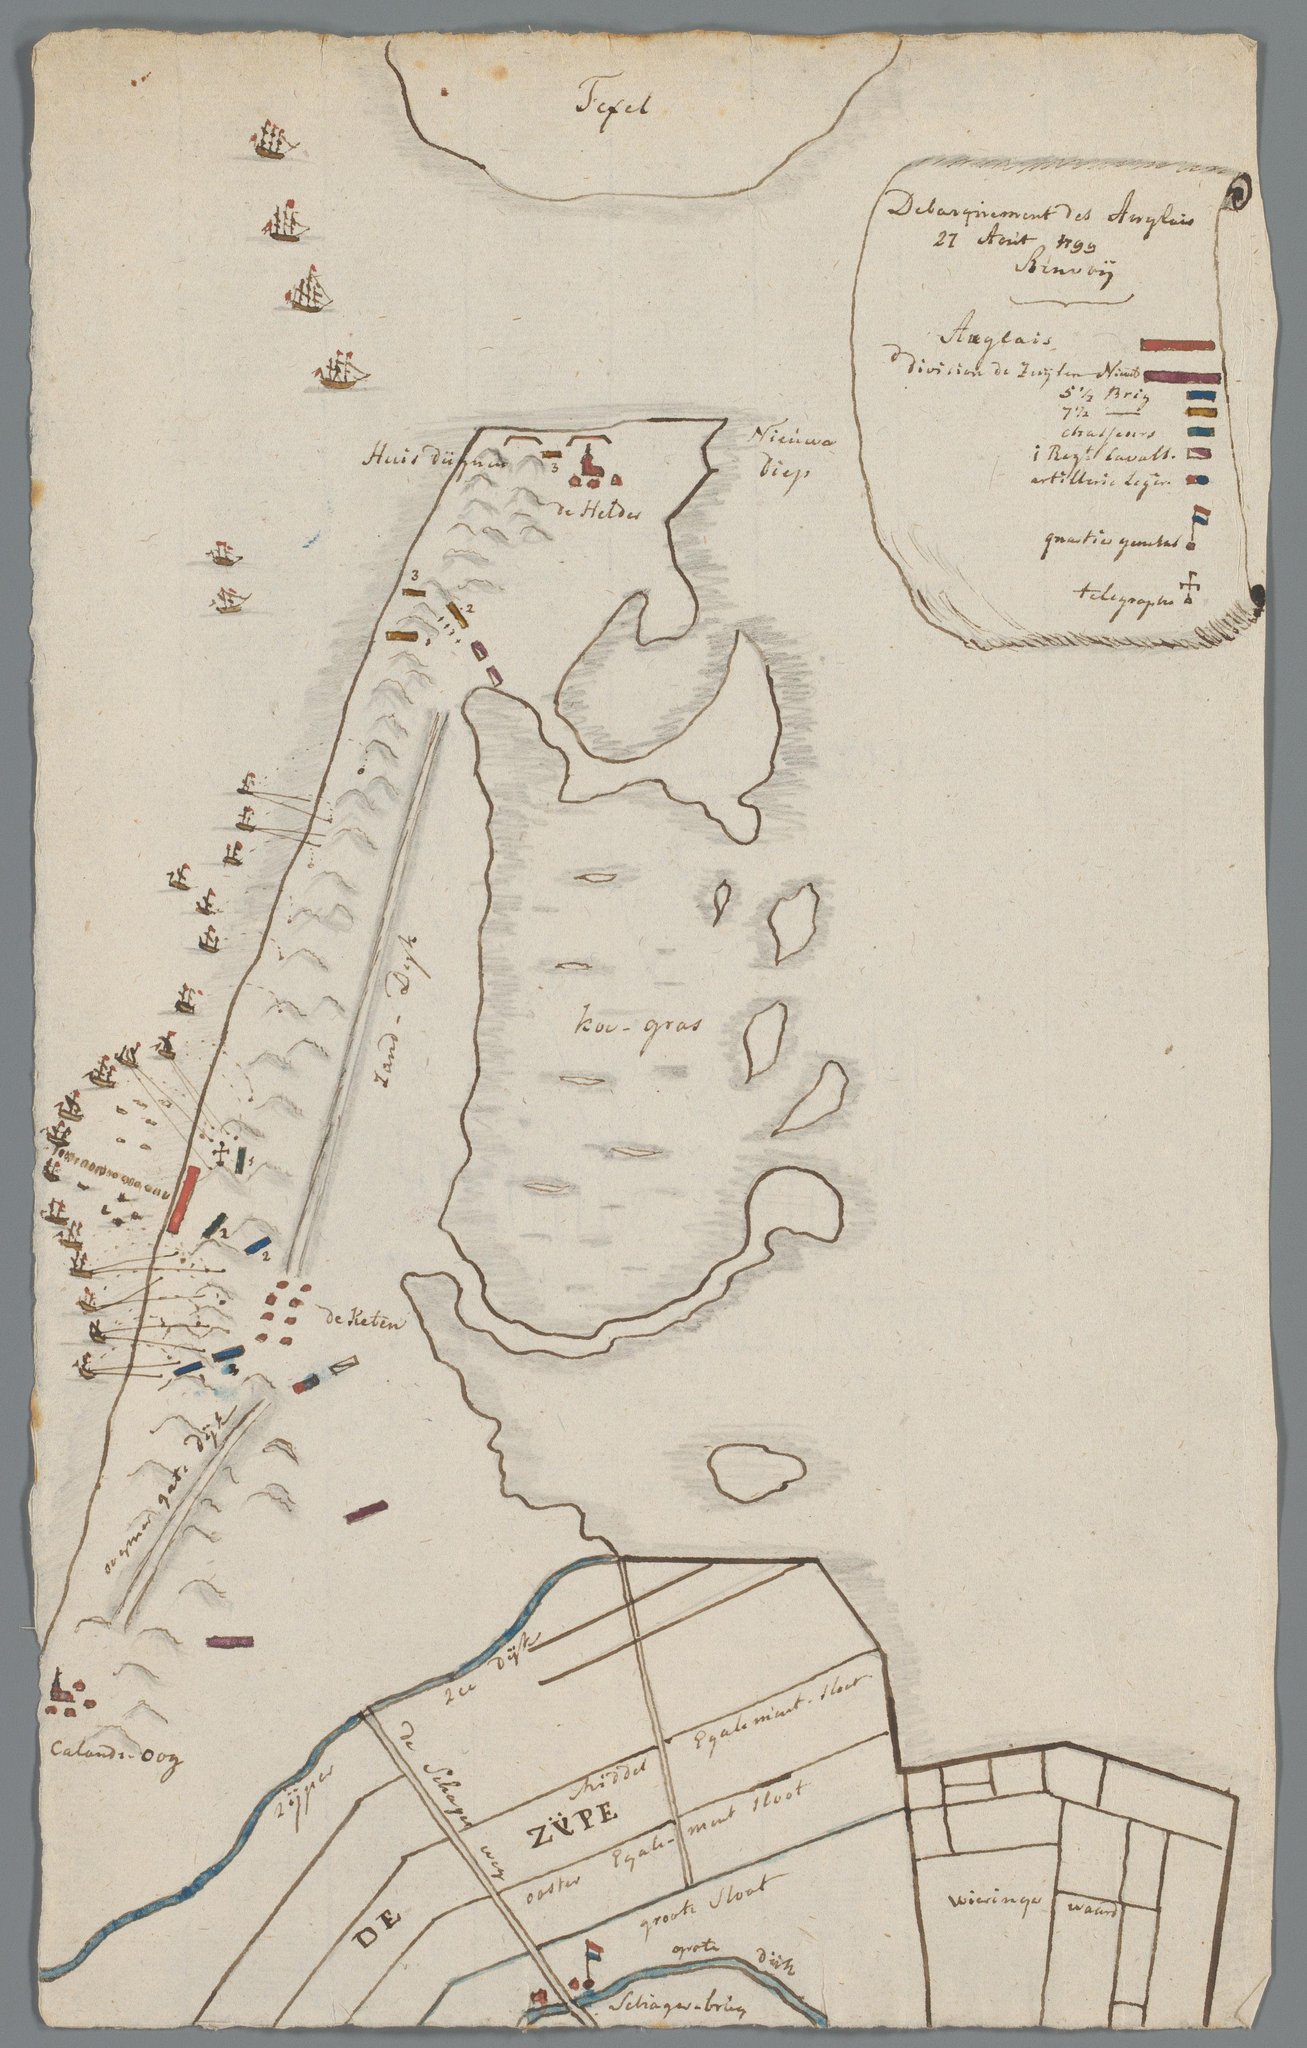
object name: drawing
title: Debarquement des Anglais 27 Aout 1799 Renvoij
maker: hendrik van der poth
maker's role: draughtsman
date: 1799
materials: paper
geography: netherlands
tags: maps of separate countries or regions, (military) attack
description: Getekende kaart van de kop van Noord-Holland met de landing van de Britse troepen op 27 augustus 1799.